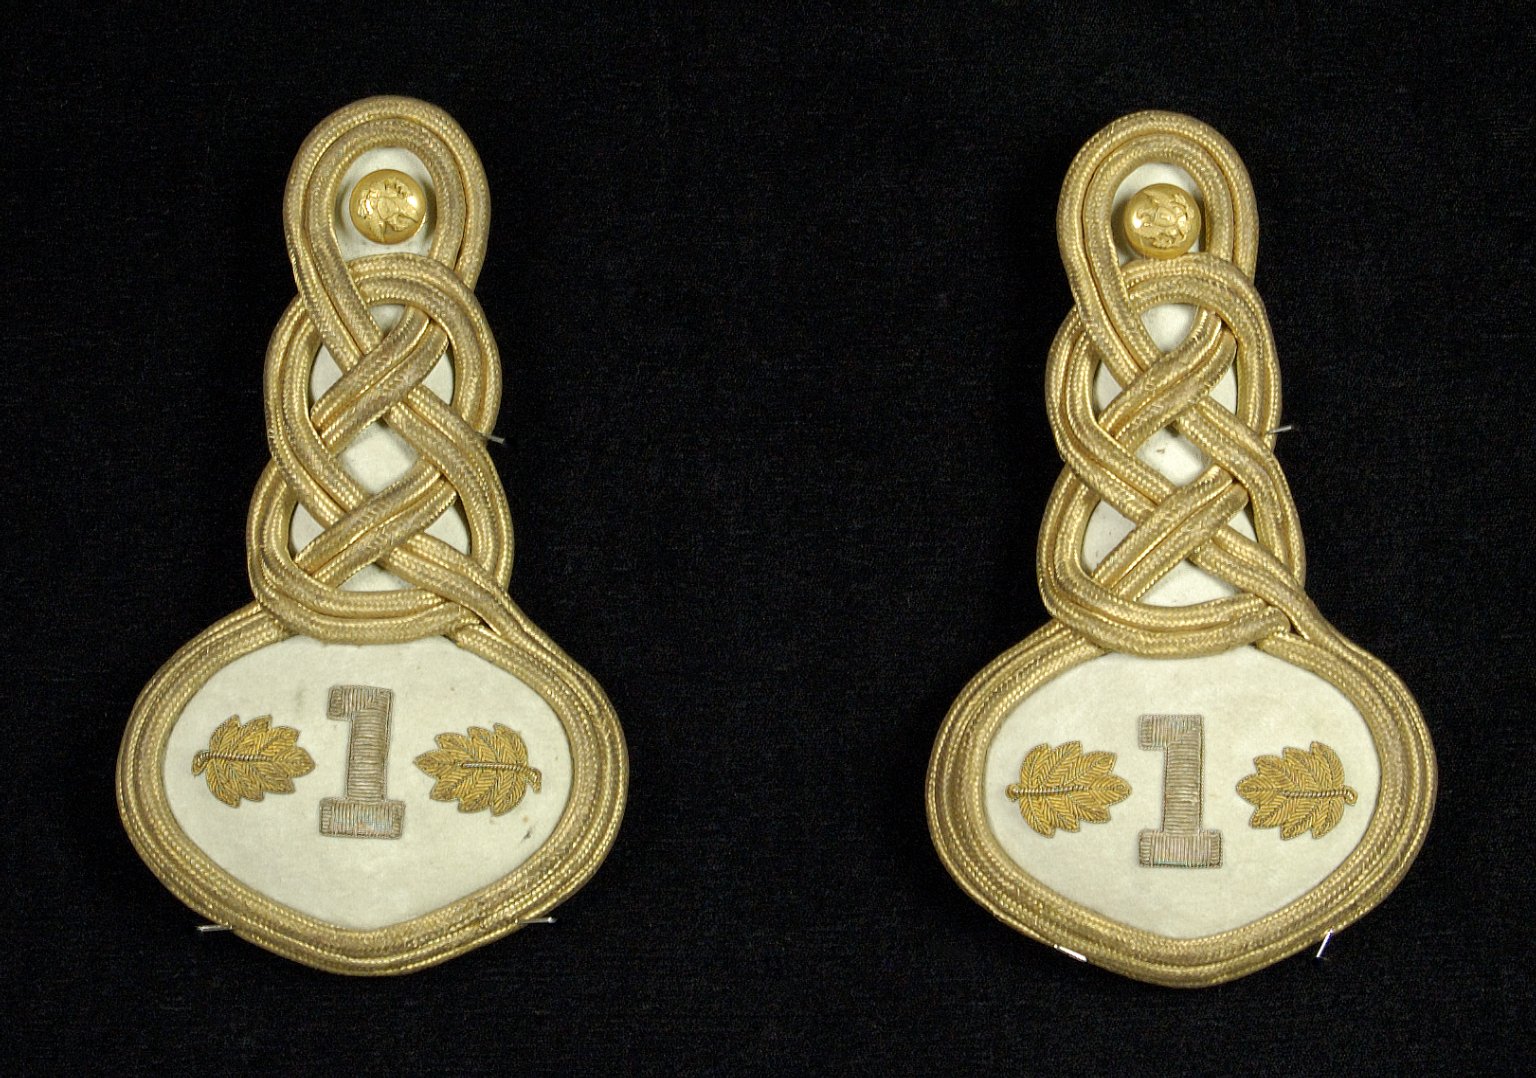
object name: epaulet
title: Epaulets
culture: american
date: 1860-1880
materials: wool